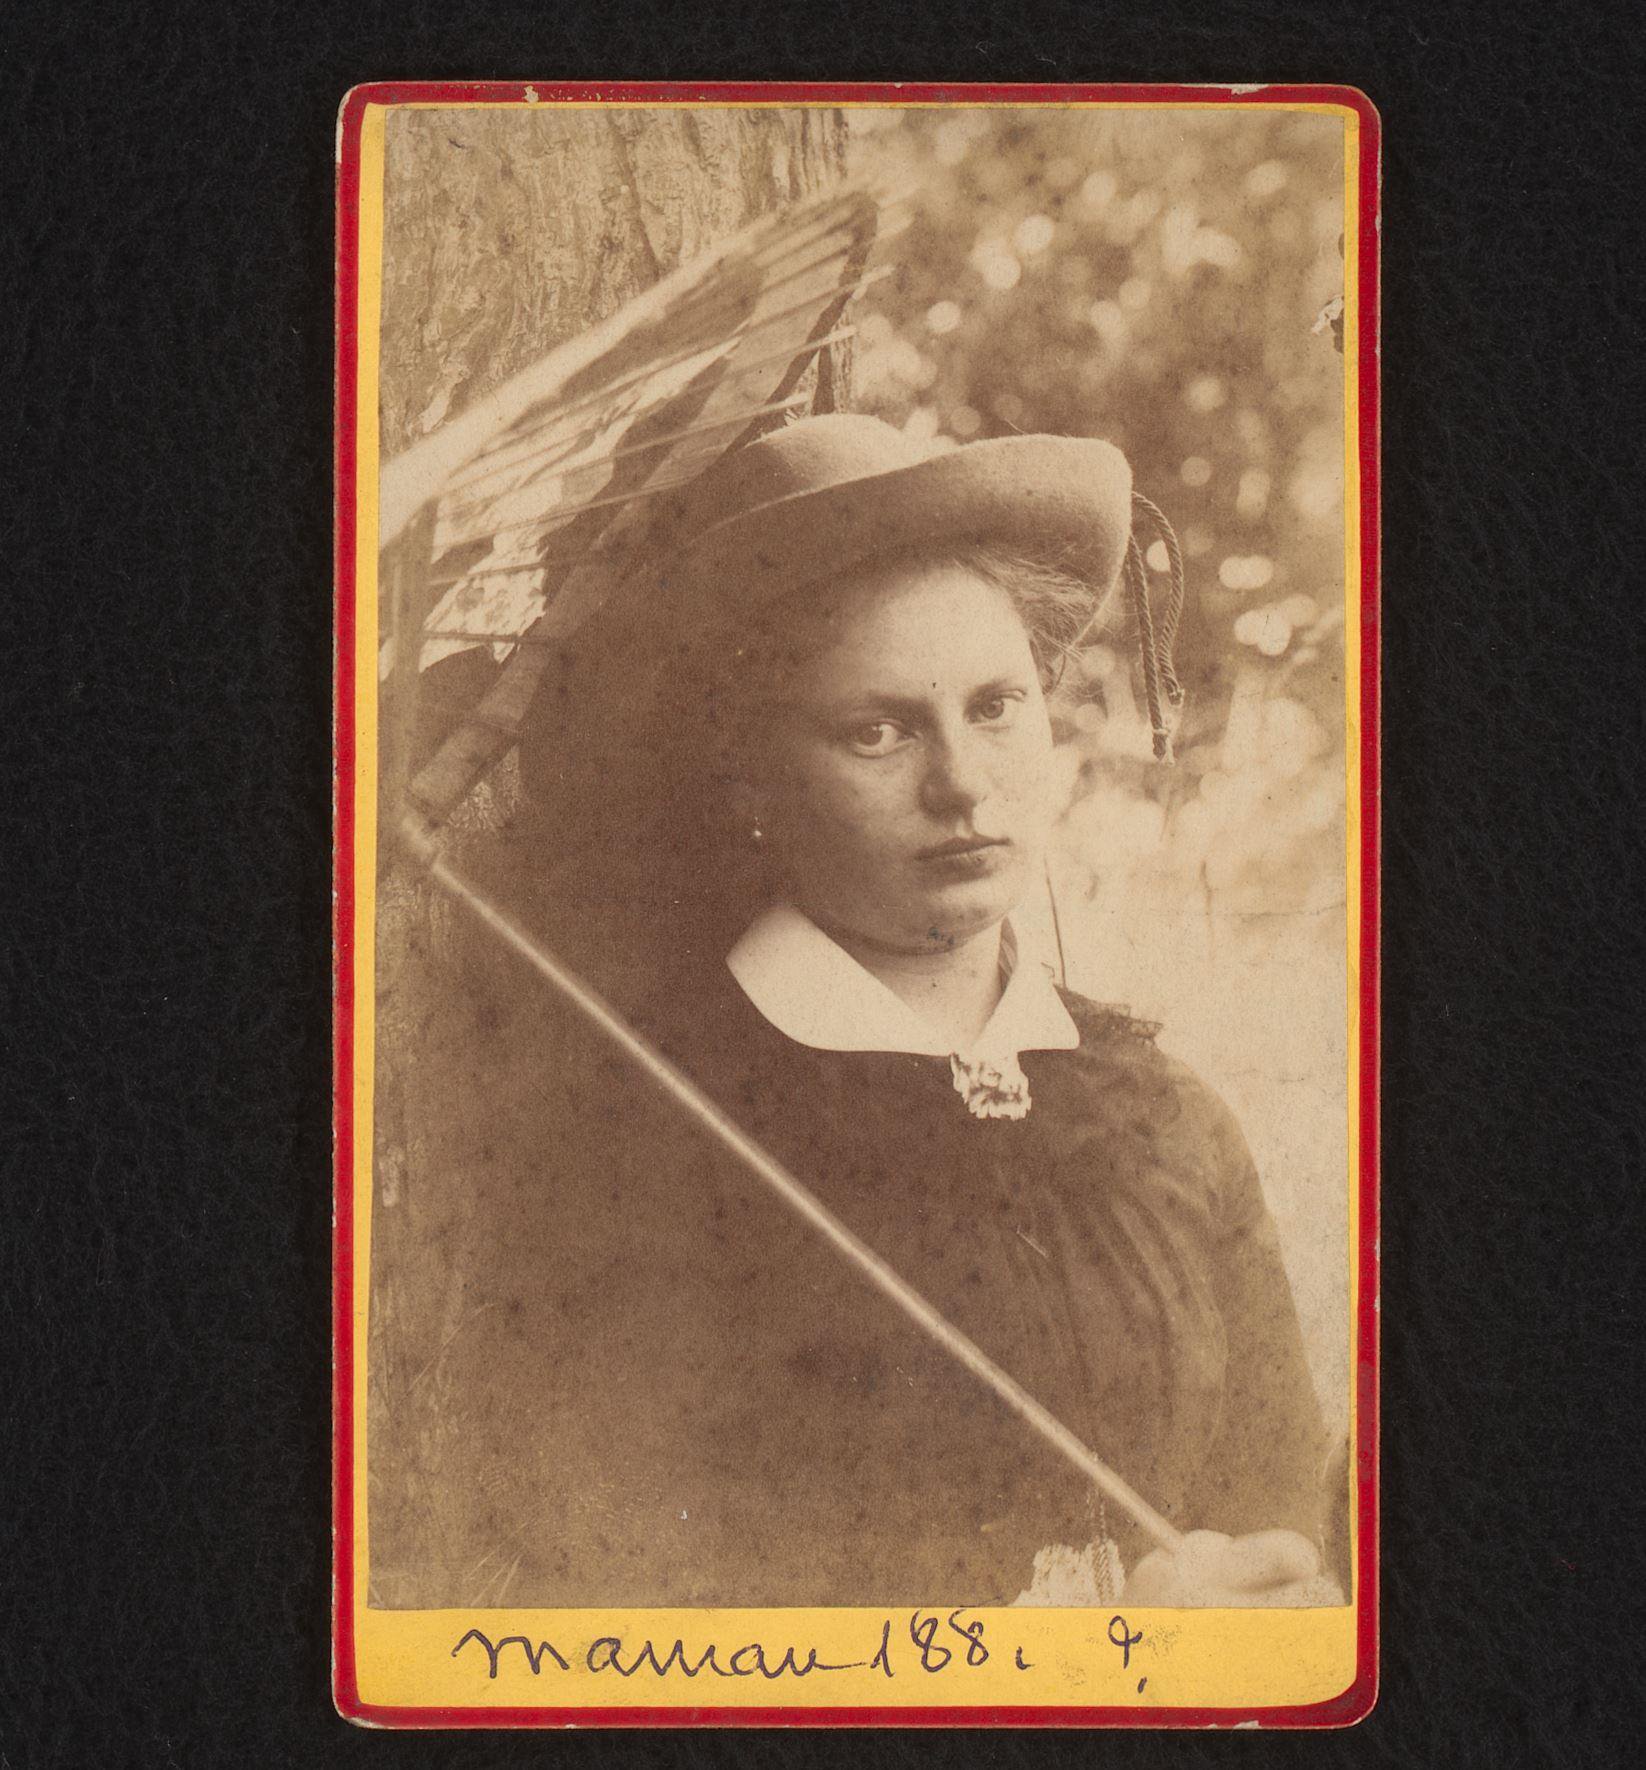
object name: photograph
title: Portret van een jonge vrouw met parasol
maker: Anonymous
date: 1881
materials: cardboard, photographic support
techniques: albumen print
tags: adolescent, young woman, maiden, historical persons, parasol, sunshade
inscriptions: annotation: ‘Maman 1881’